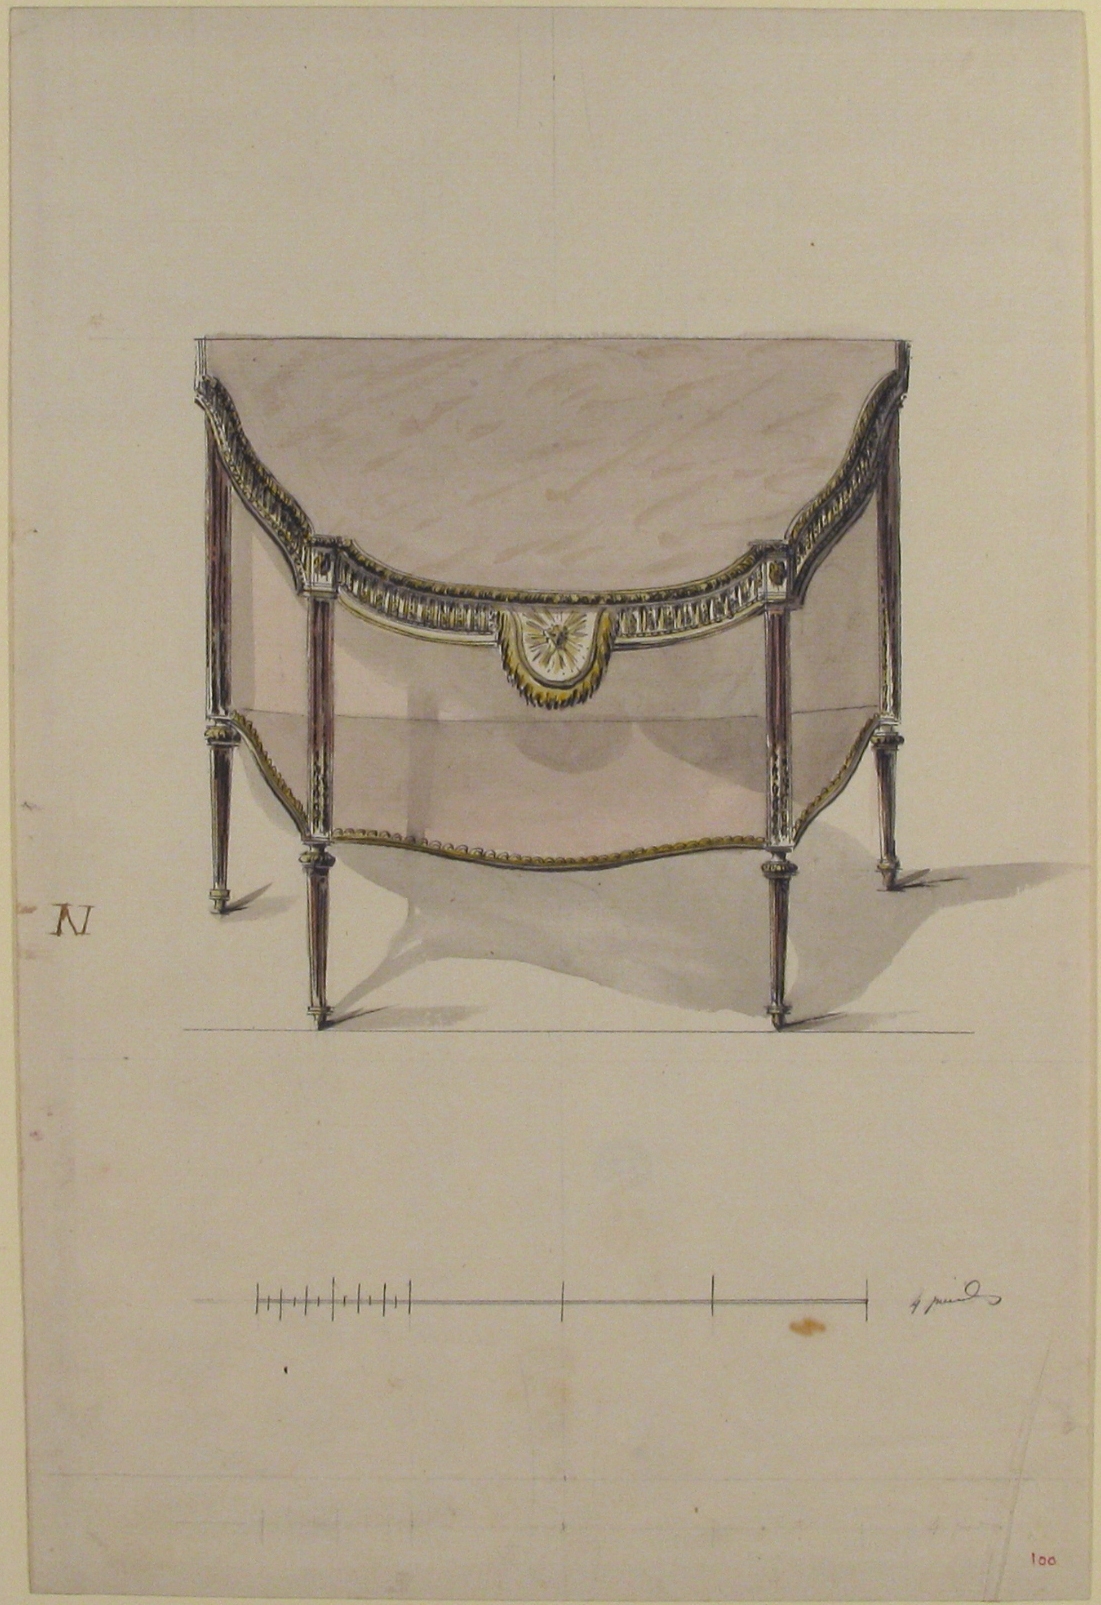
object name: drawing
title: Design for a Console Table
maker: anonymous, french, 18th century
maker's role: artist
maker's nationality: french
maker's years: 1700-1800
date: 1770-1785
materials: ink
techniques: brush, pen, wash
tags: tables